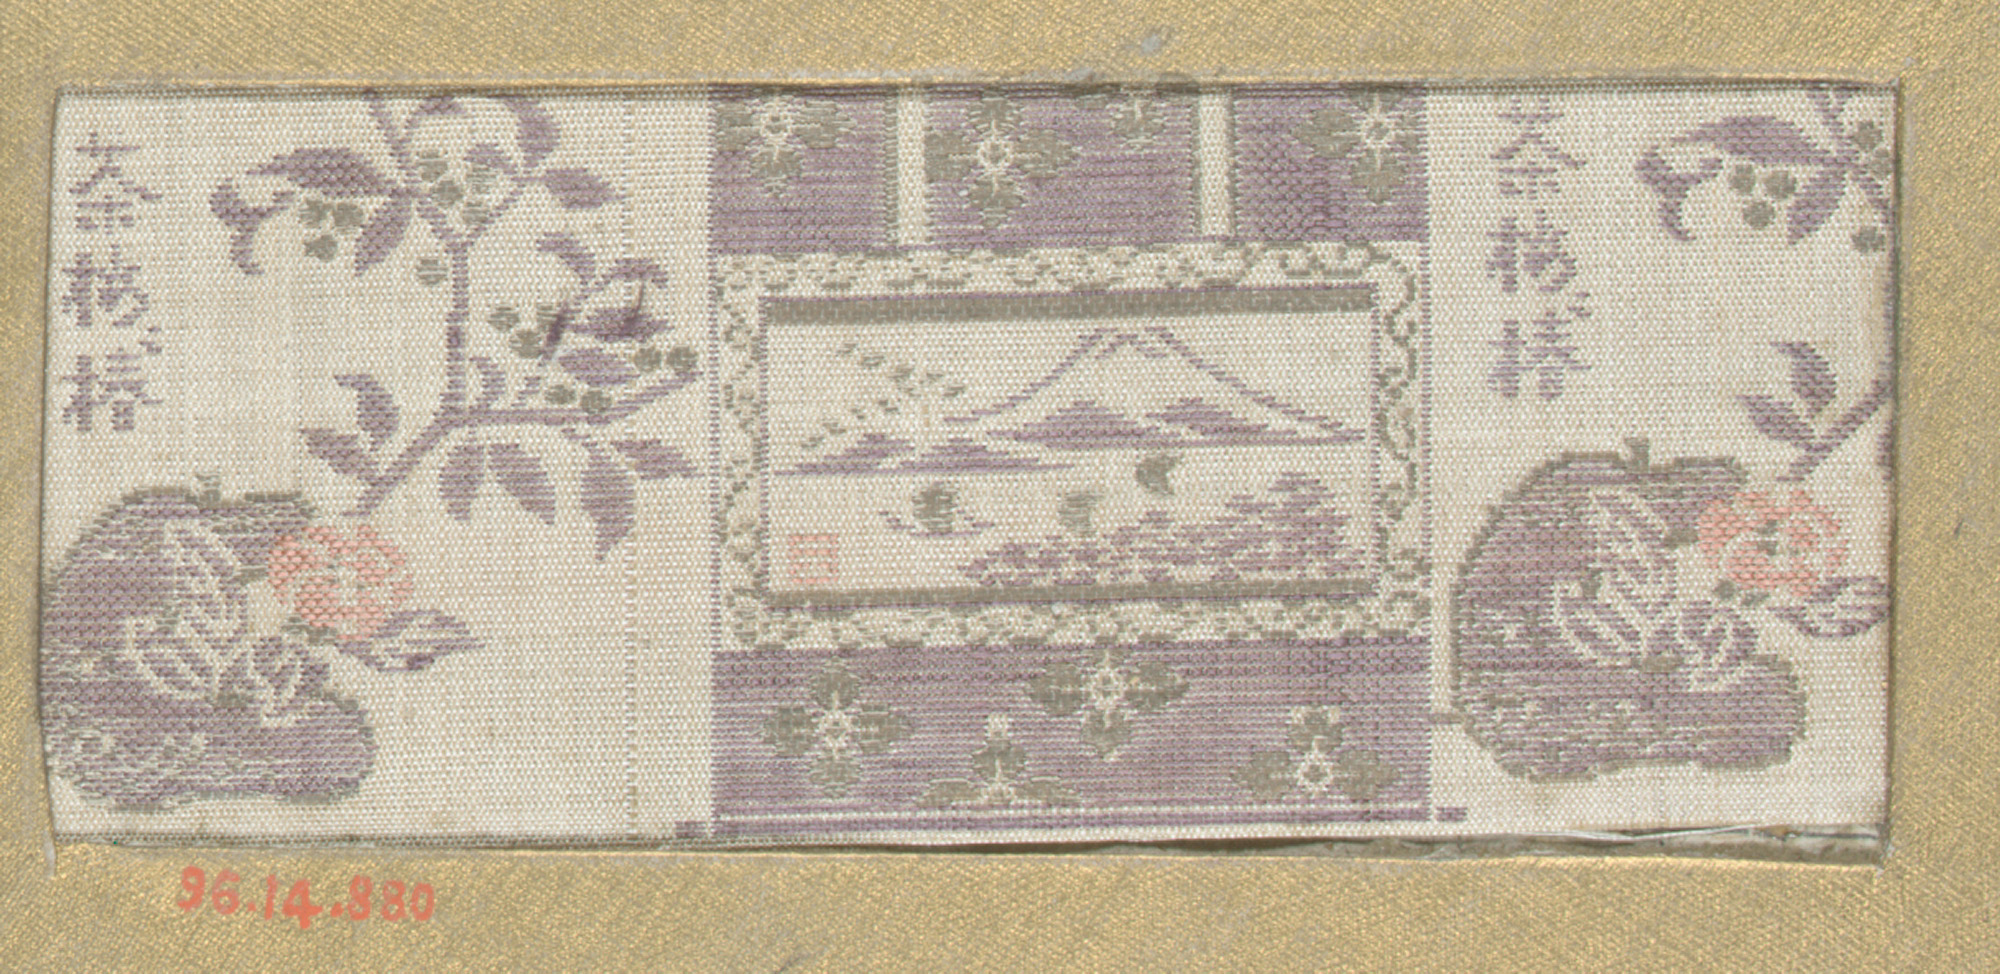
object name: piece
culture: japanese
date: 1701-1900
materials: silk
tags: landscapes,plants